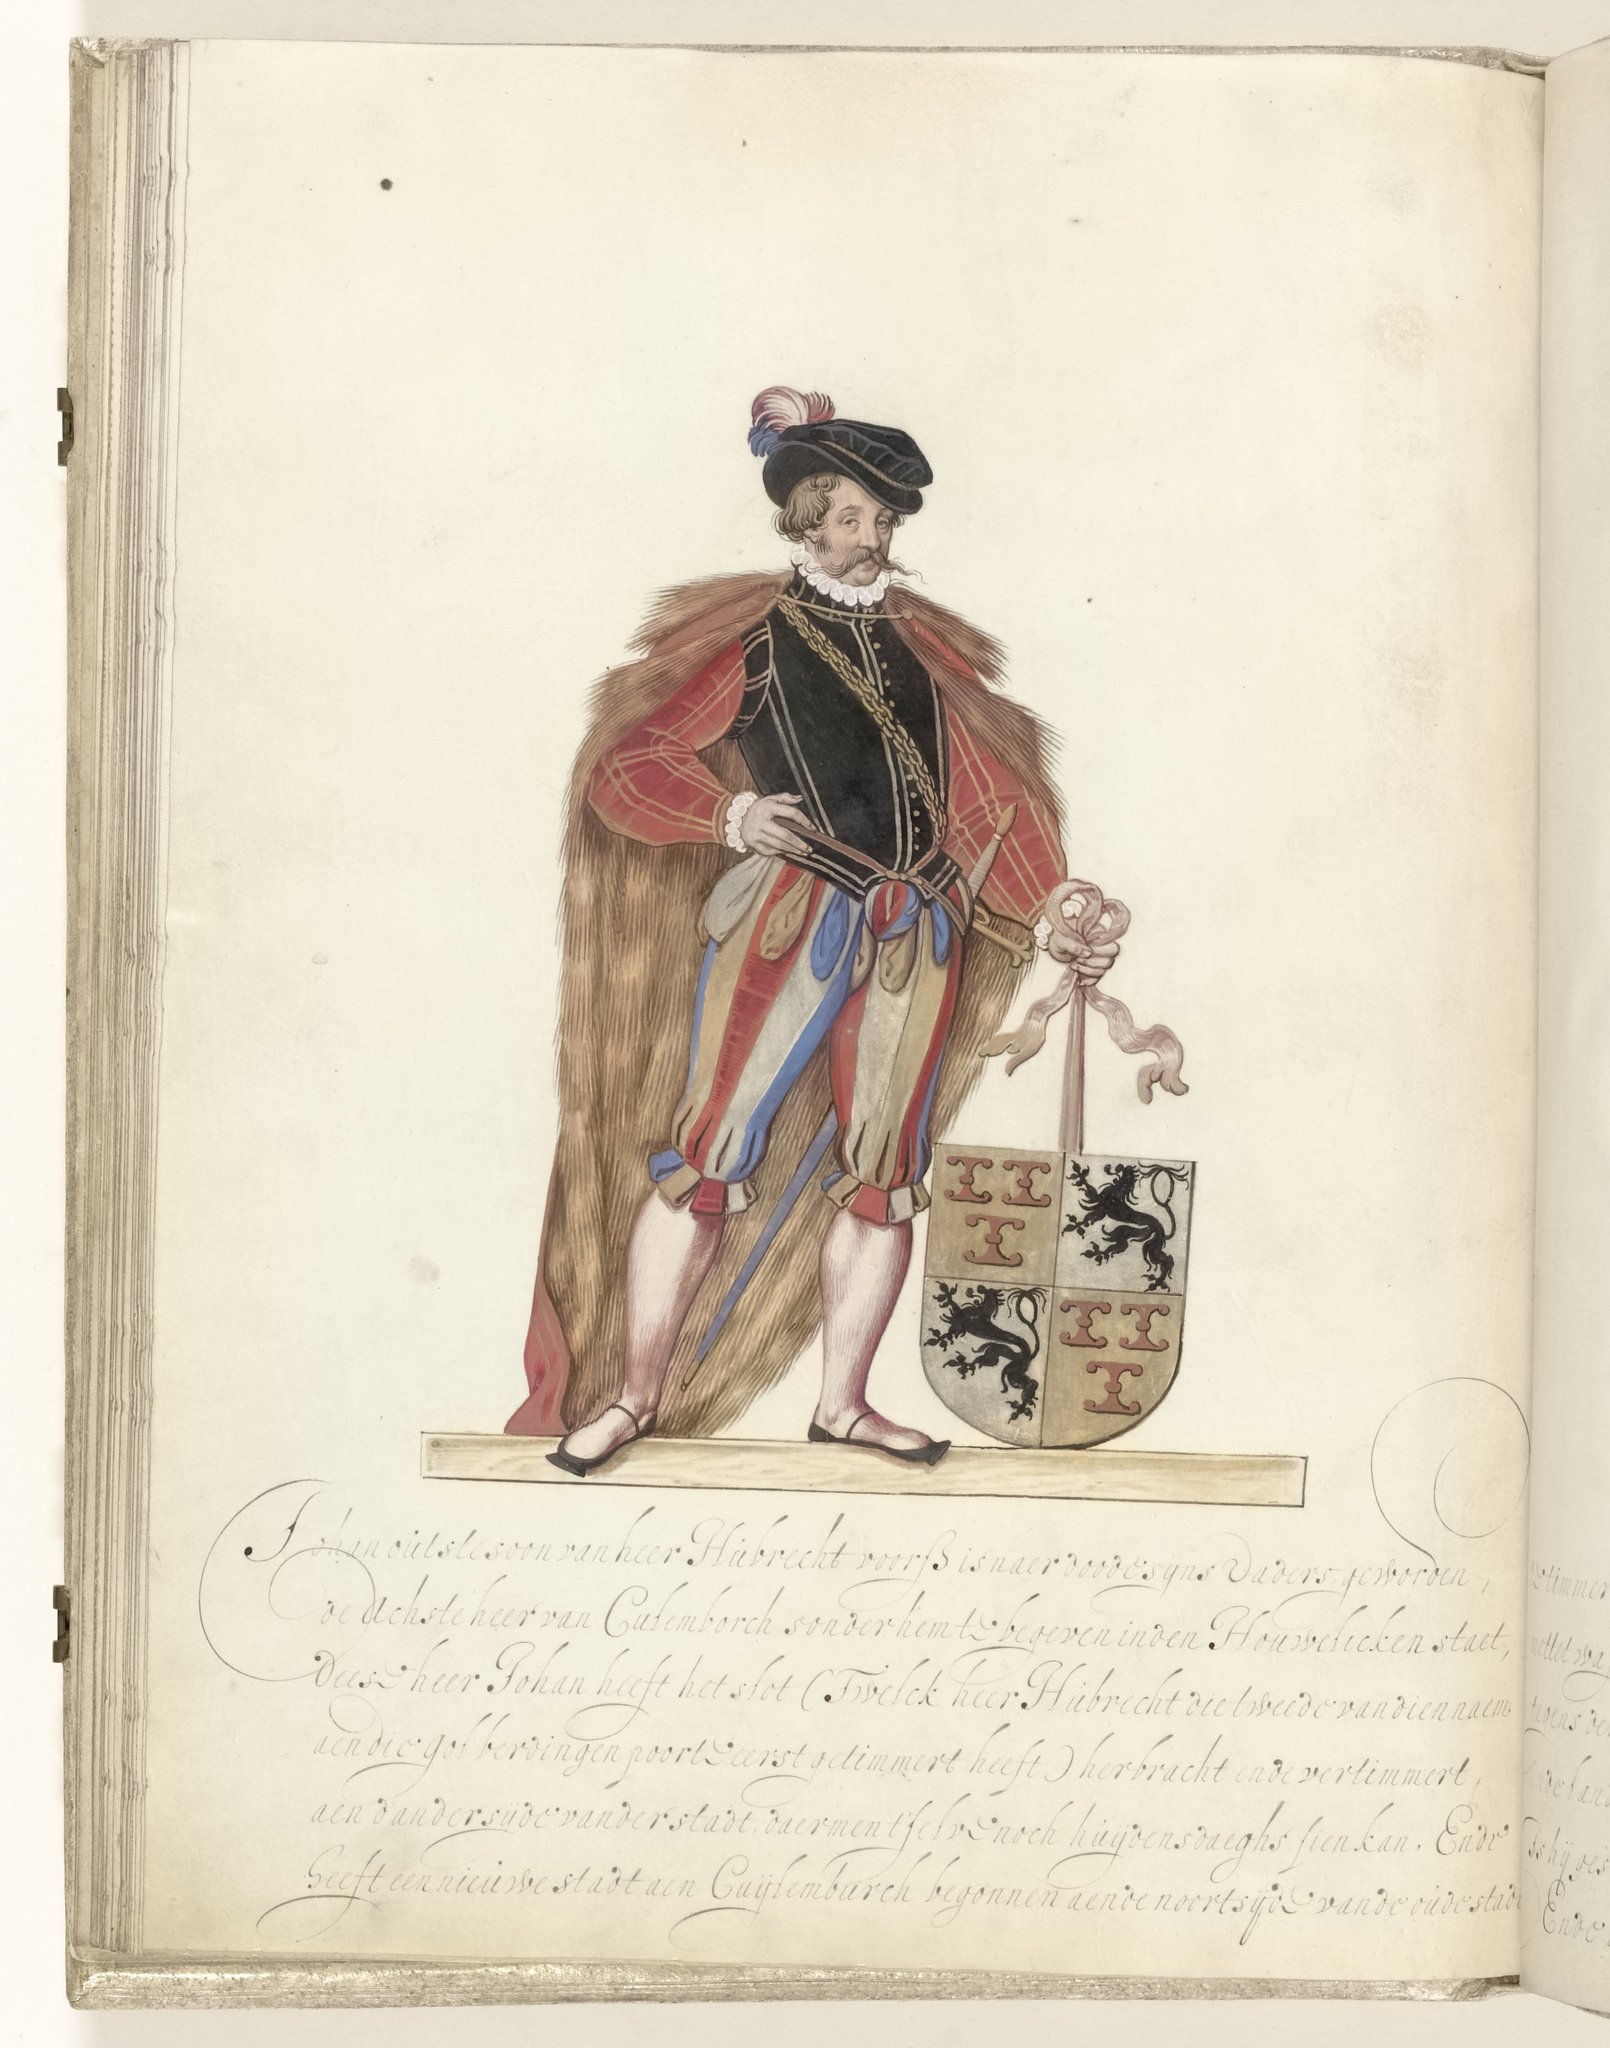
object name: drawing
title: Johan II, heer van Culemborg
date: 1590-1593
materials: paint, gouache, ink, parchment, watercolor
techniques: writing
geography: northern netherlands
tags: culemborg, heren en graven van, johan heer van culemborg (ii), culemborg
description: Johan II, achtste heer van Culemborg. Staande ten voeten uit met het gevierendeelde wapen van Culemborg en van de Leck. Onderdeel van een geïllustreerd handschrift met de genealogie van de heren en graven van Culemborg.